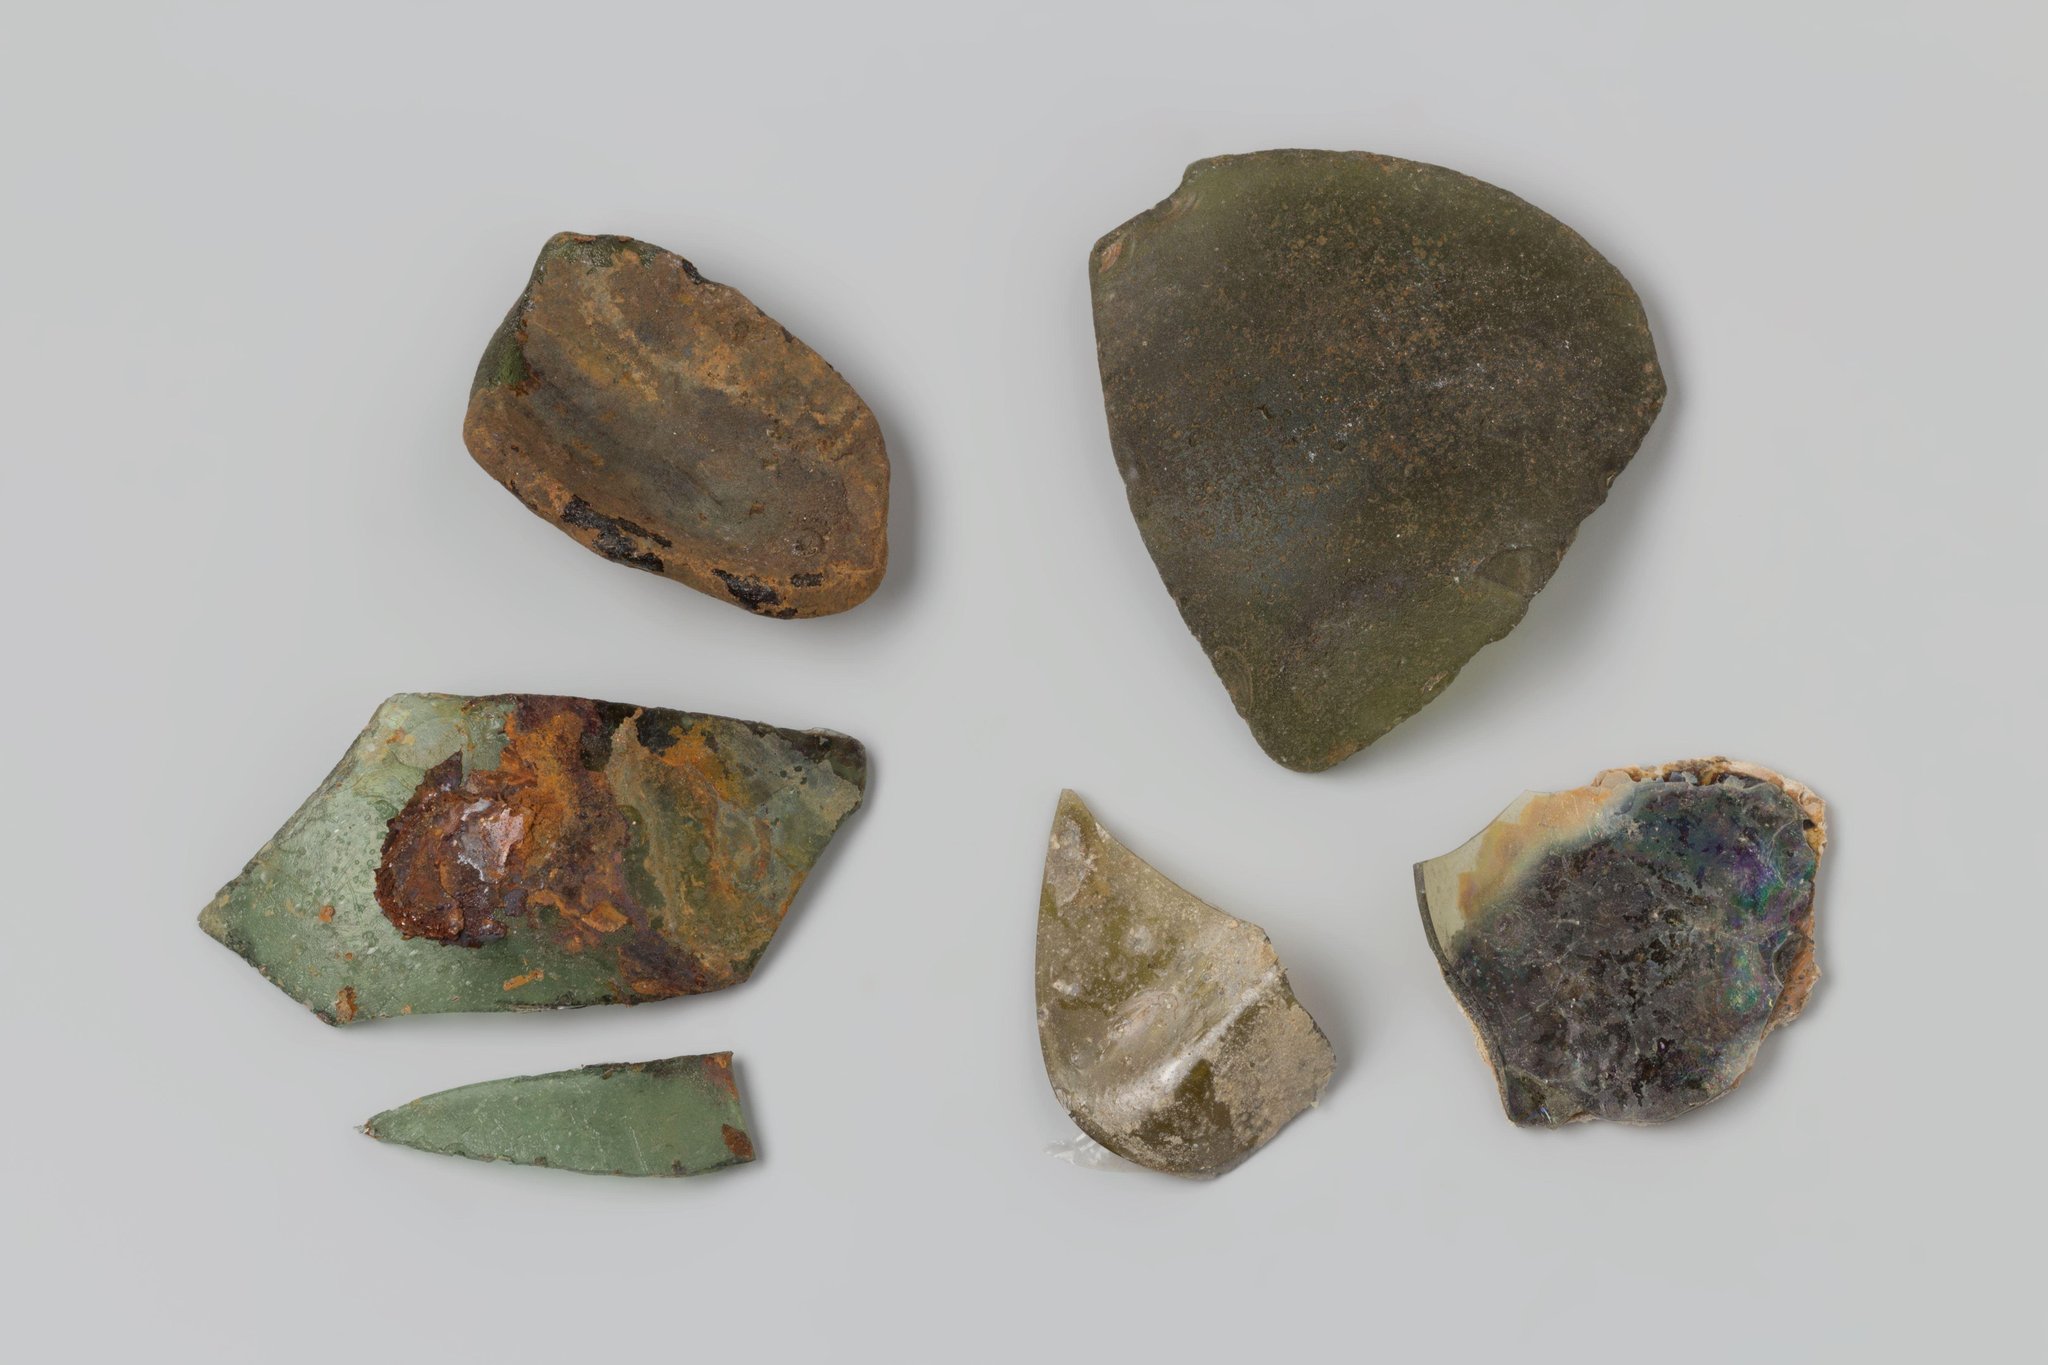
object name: sherd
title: Scherven van kistflessen uit V.O.C.-schip de 'Witte Leeuw'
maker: Anonymous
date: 1613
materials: glass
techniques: green glass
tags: verenigde oostindische compagnie, sint-helena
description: Scherven van kistflessen uit V.O.C.-schip de 'Witte Leeuw', van groen glas. Concretie, koraalachtige aanslag en bruine aanslag aanwezig.